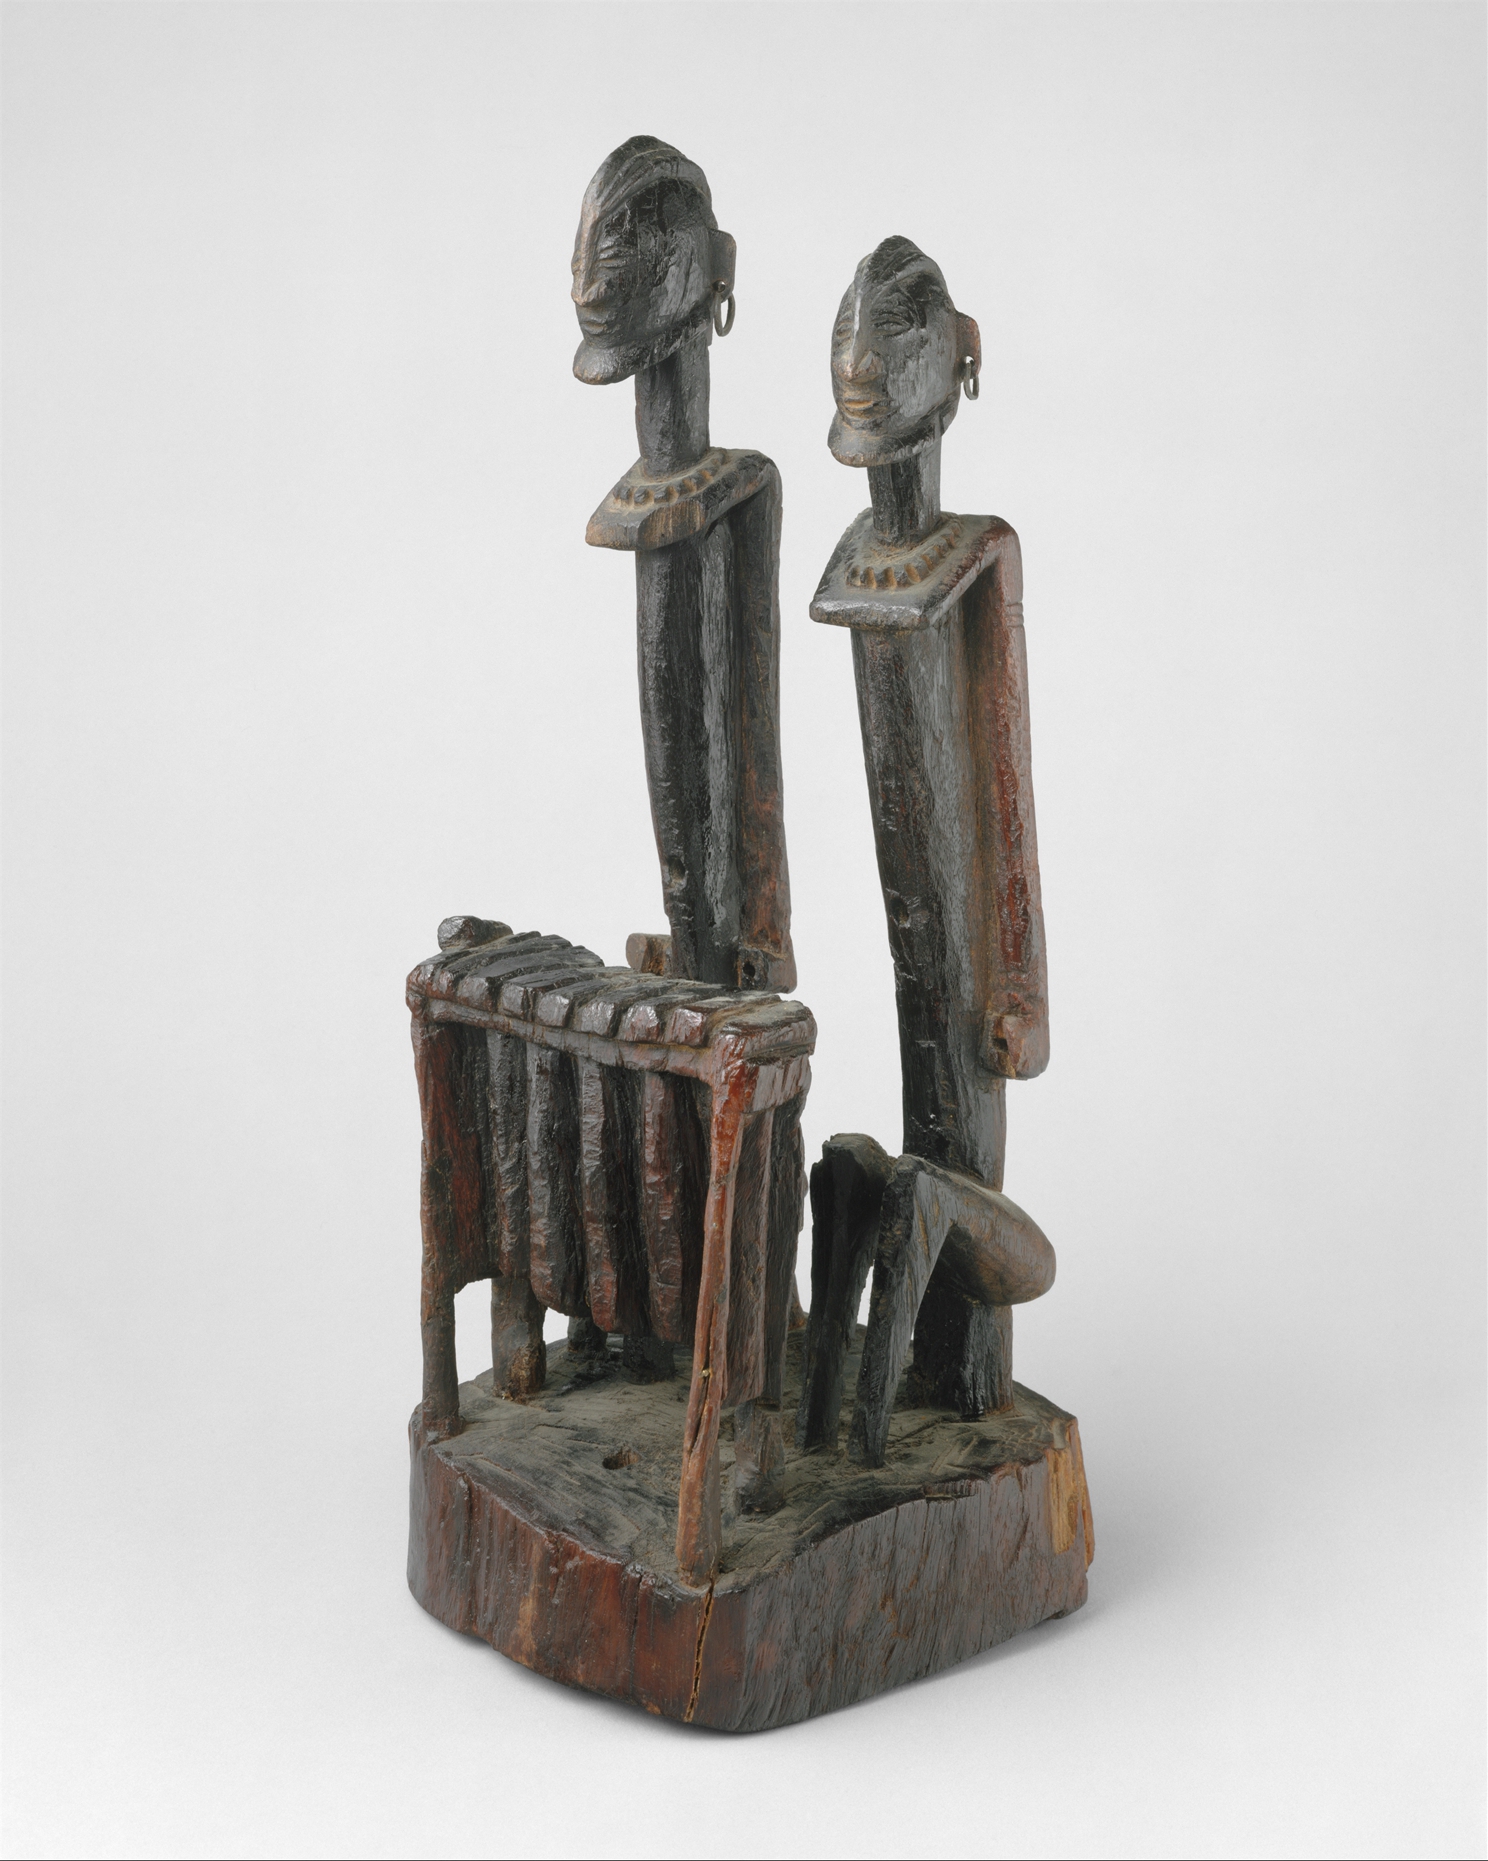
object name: one of a pair of figure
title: Pair of bala players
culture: dogon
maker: dogon blacksmith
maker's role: artist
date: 1701-1833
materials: metal, wood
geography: mali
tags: human figures,musical instruments